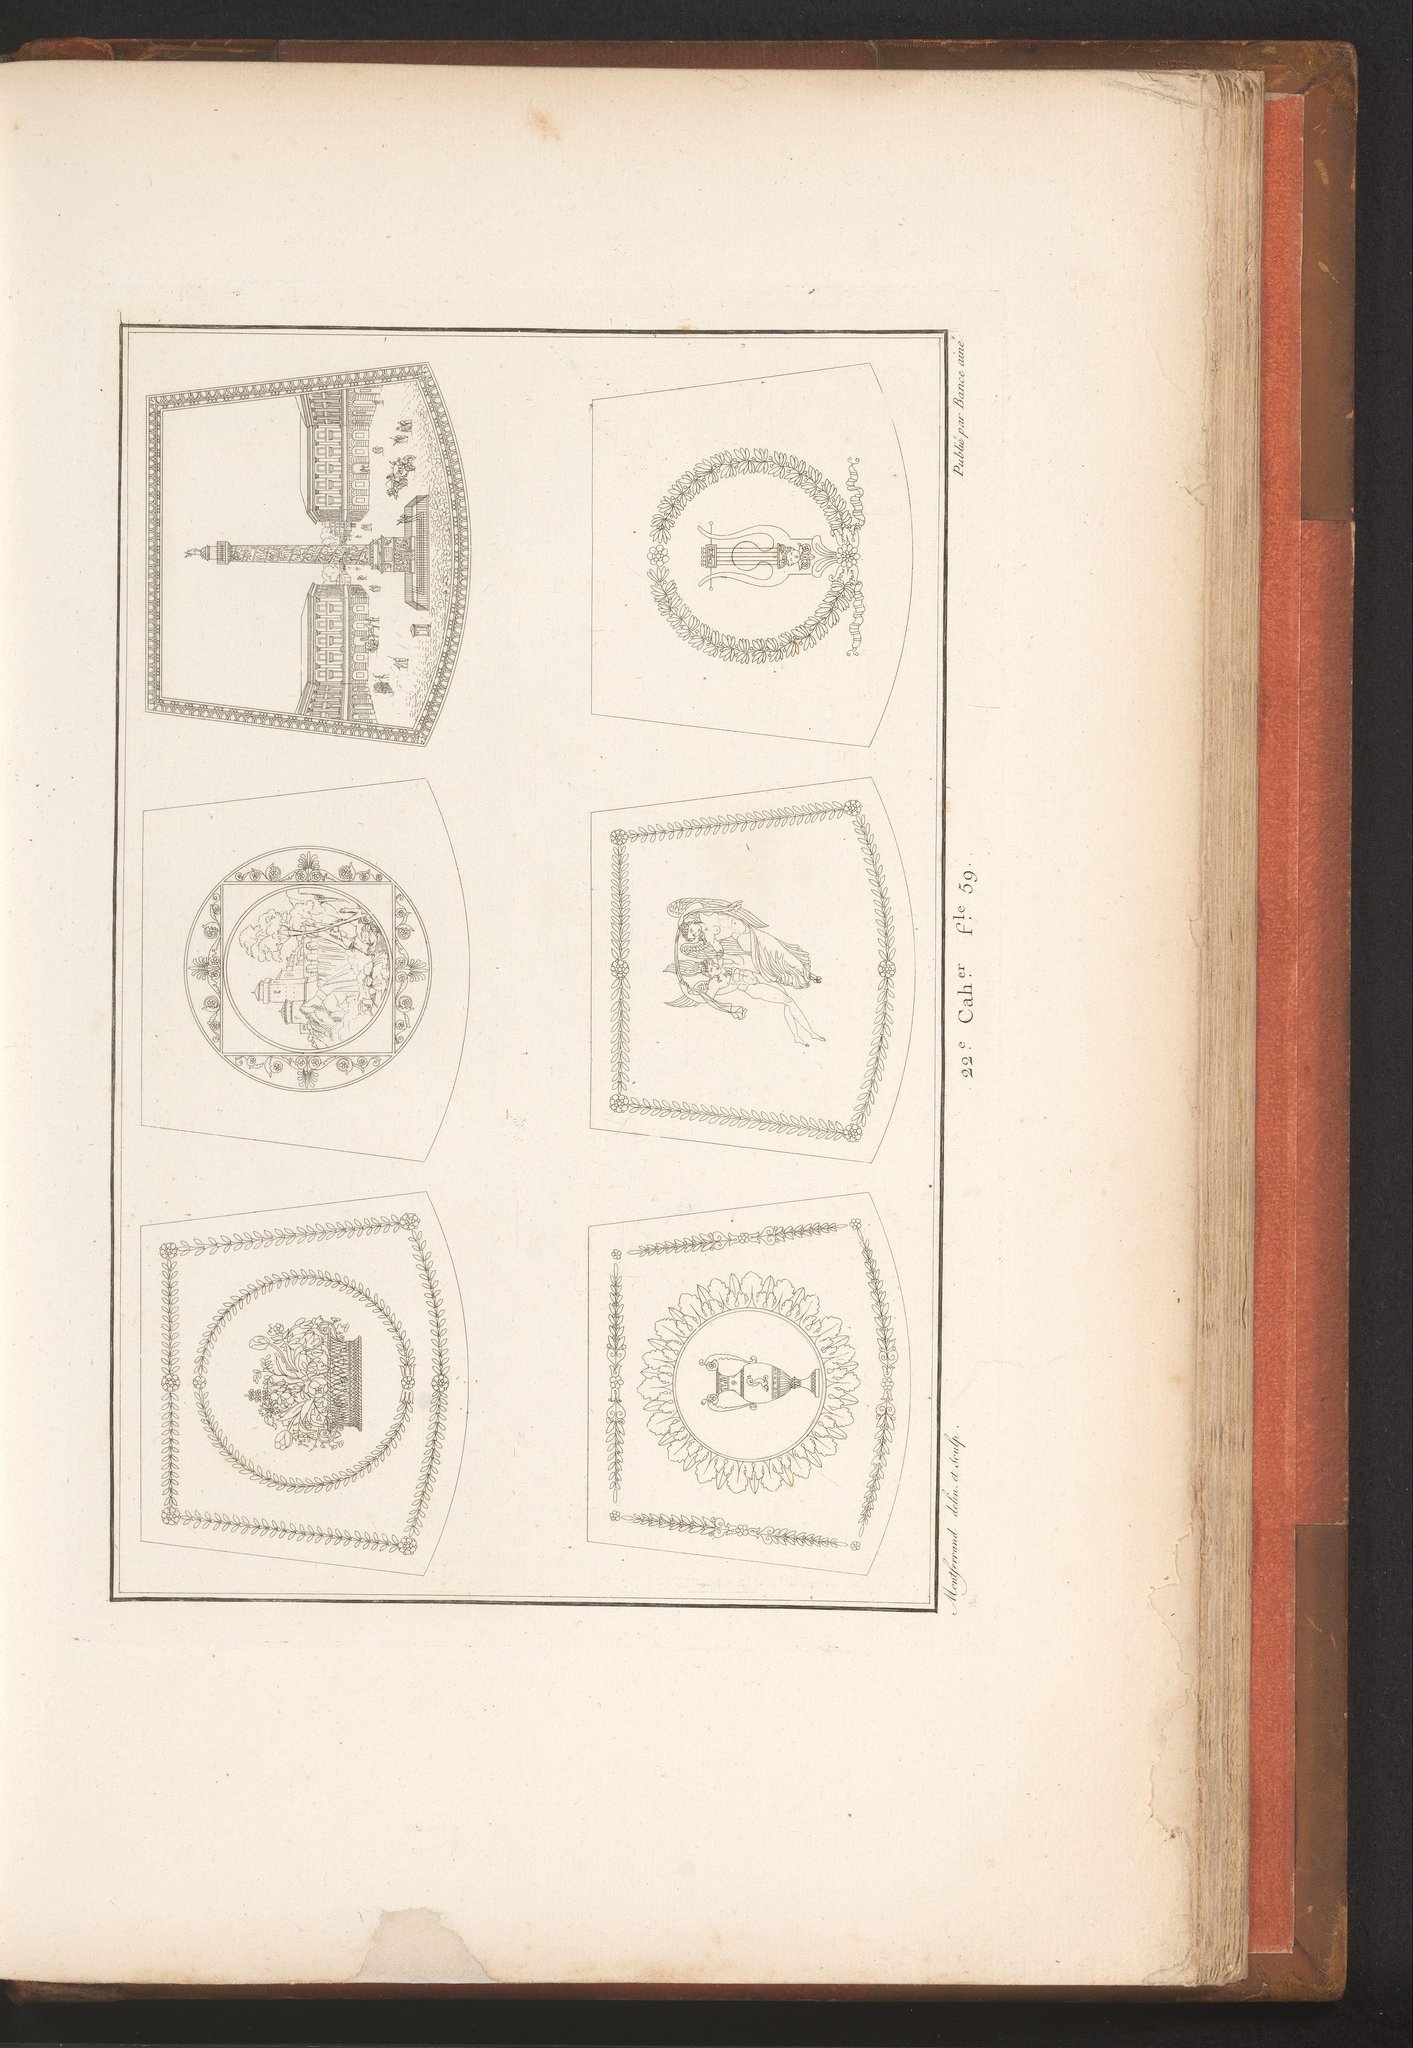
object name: ornament print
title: Decoraties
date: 1820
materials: paper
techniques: etching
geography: paris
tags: decorative furniture, ornaments ~ art, carpet, rug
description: Zes ontwerpen voor decoraties, mogelijk een soort van (wand)kleden. Onderdeel (22e. Cah.er f.le 59) van het prentalbum met twee series van in totaal 138 ornamentprenten door Beauvallet en Normand, 'Fragmens d'Ornemens dans le Style Antique'.